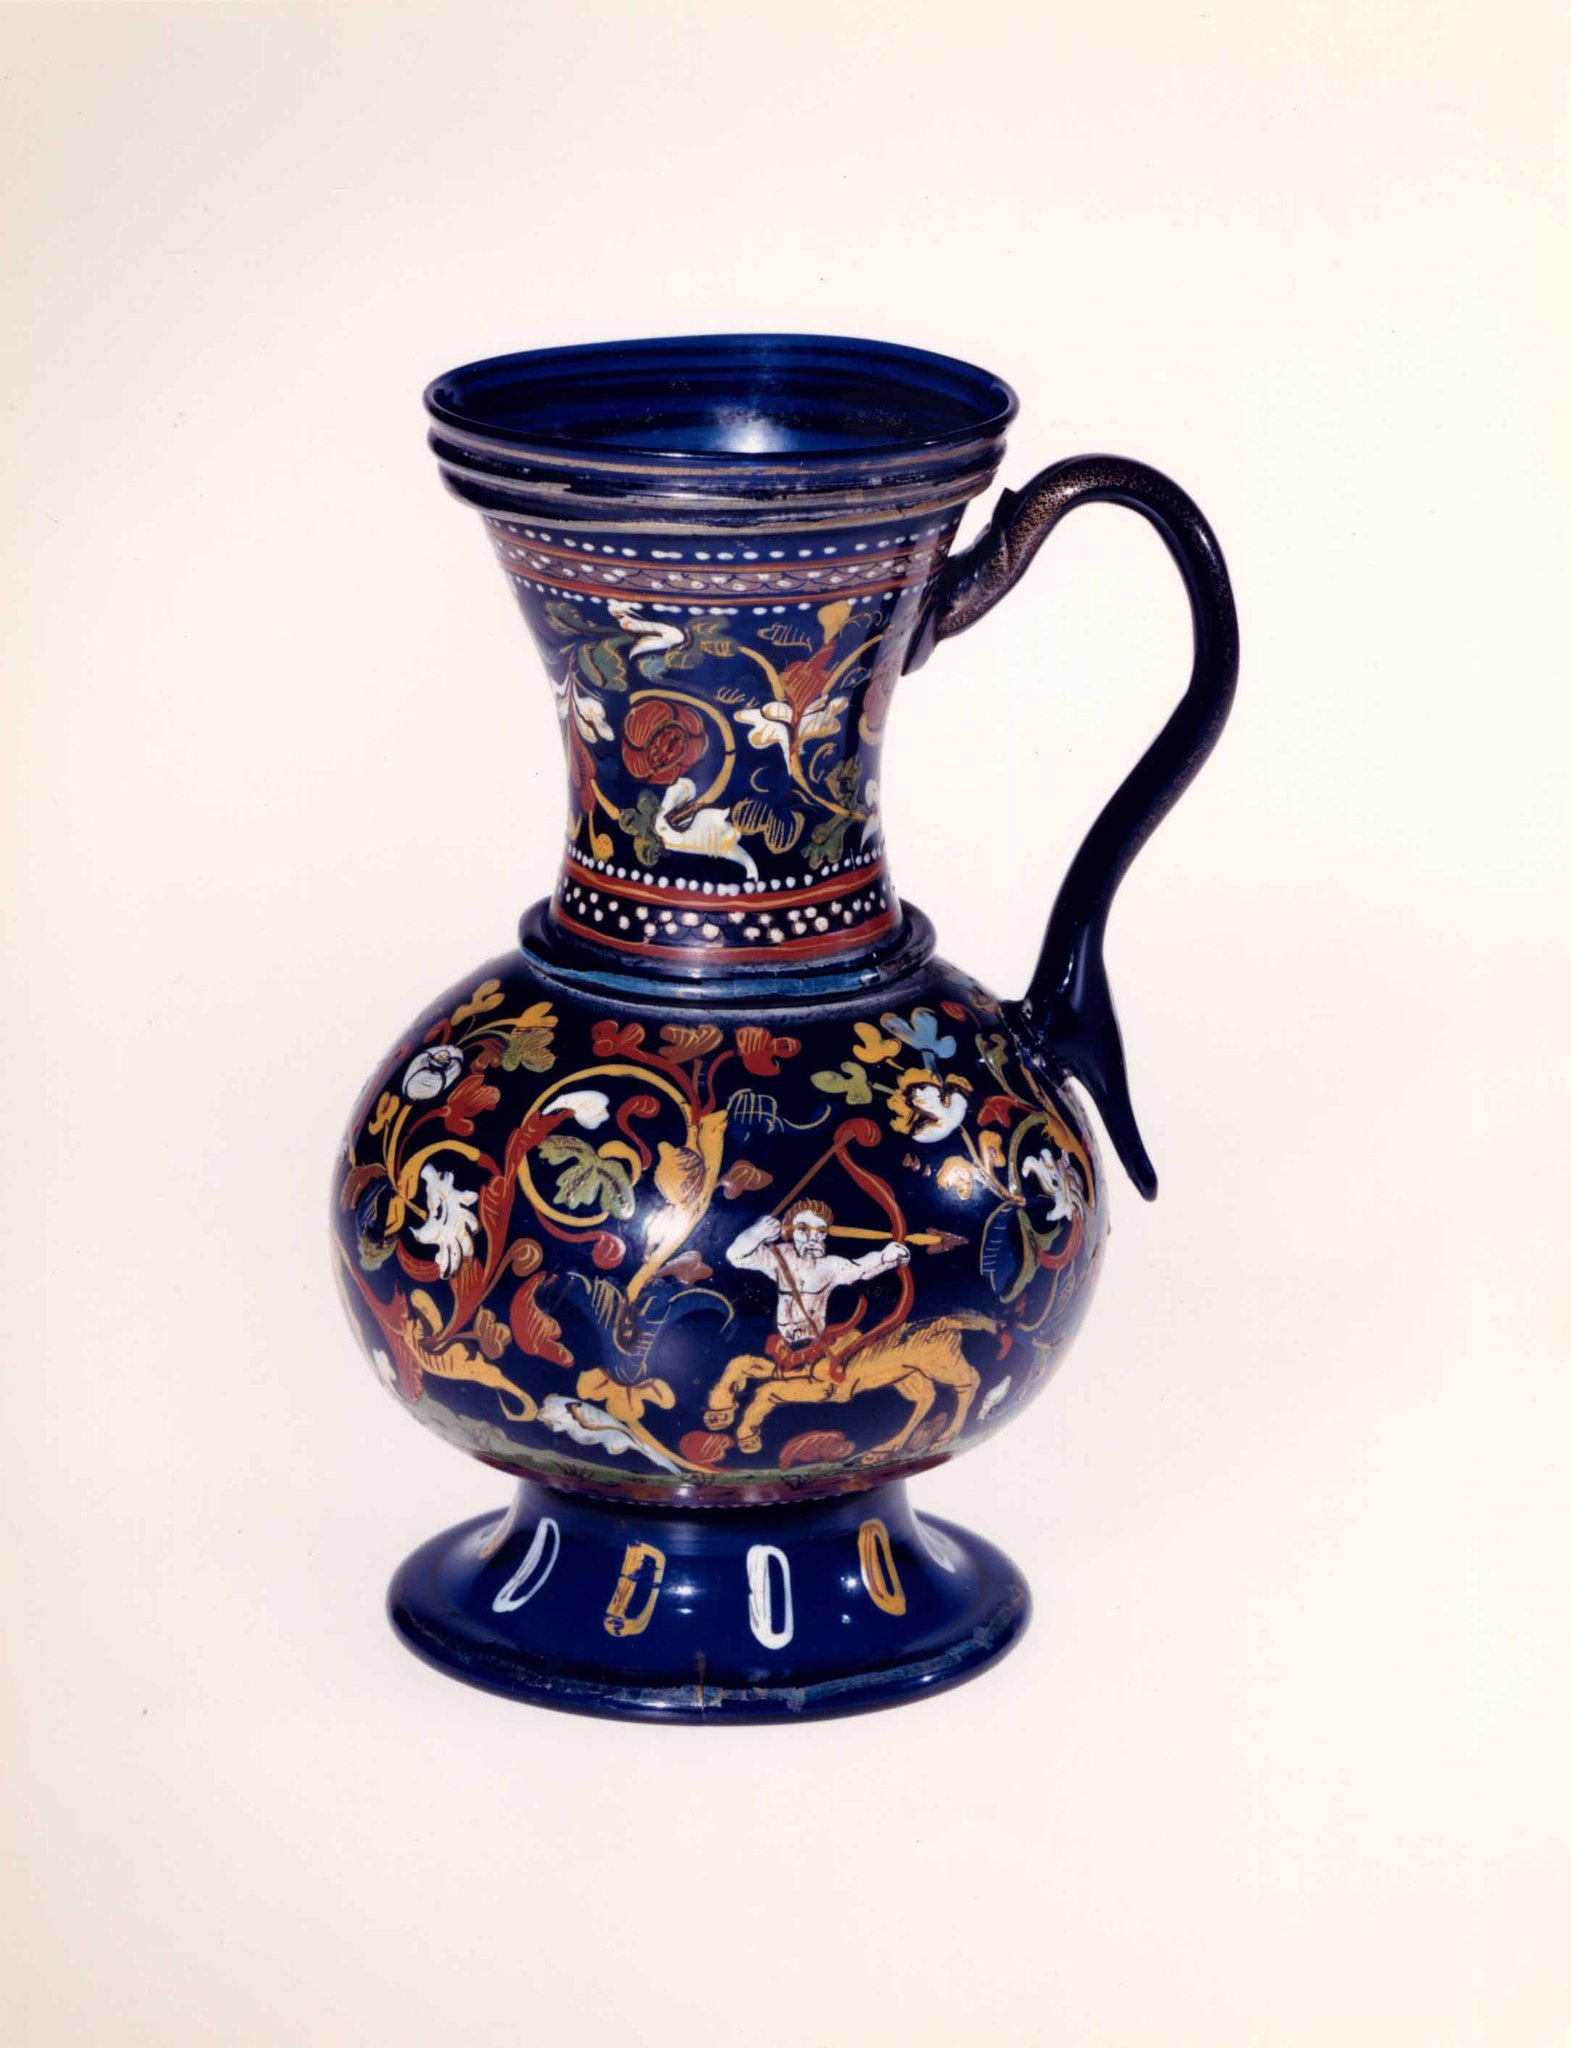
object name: jug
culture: italian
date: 1500-1510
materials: gilt, glass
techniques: glassblowing, enamel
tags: centaurs